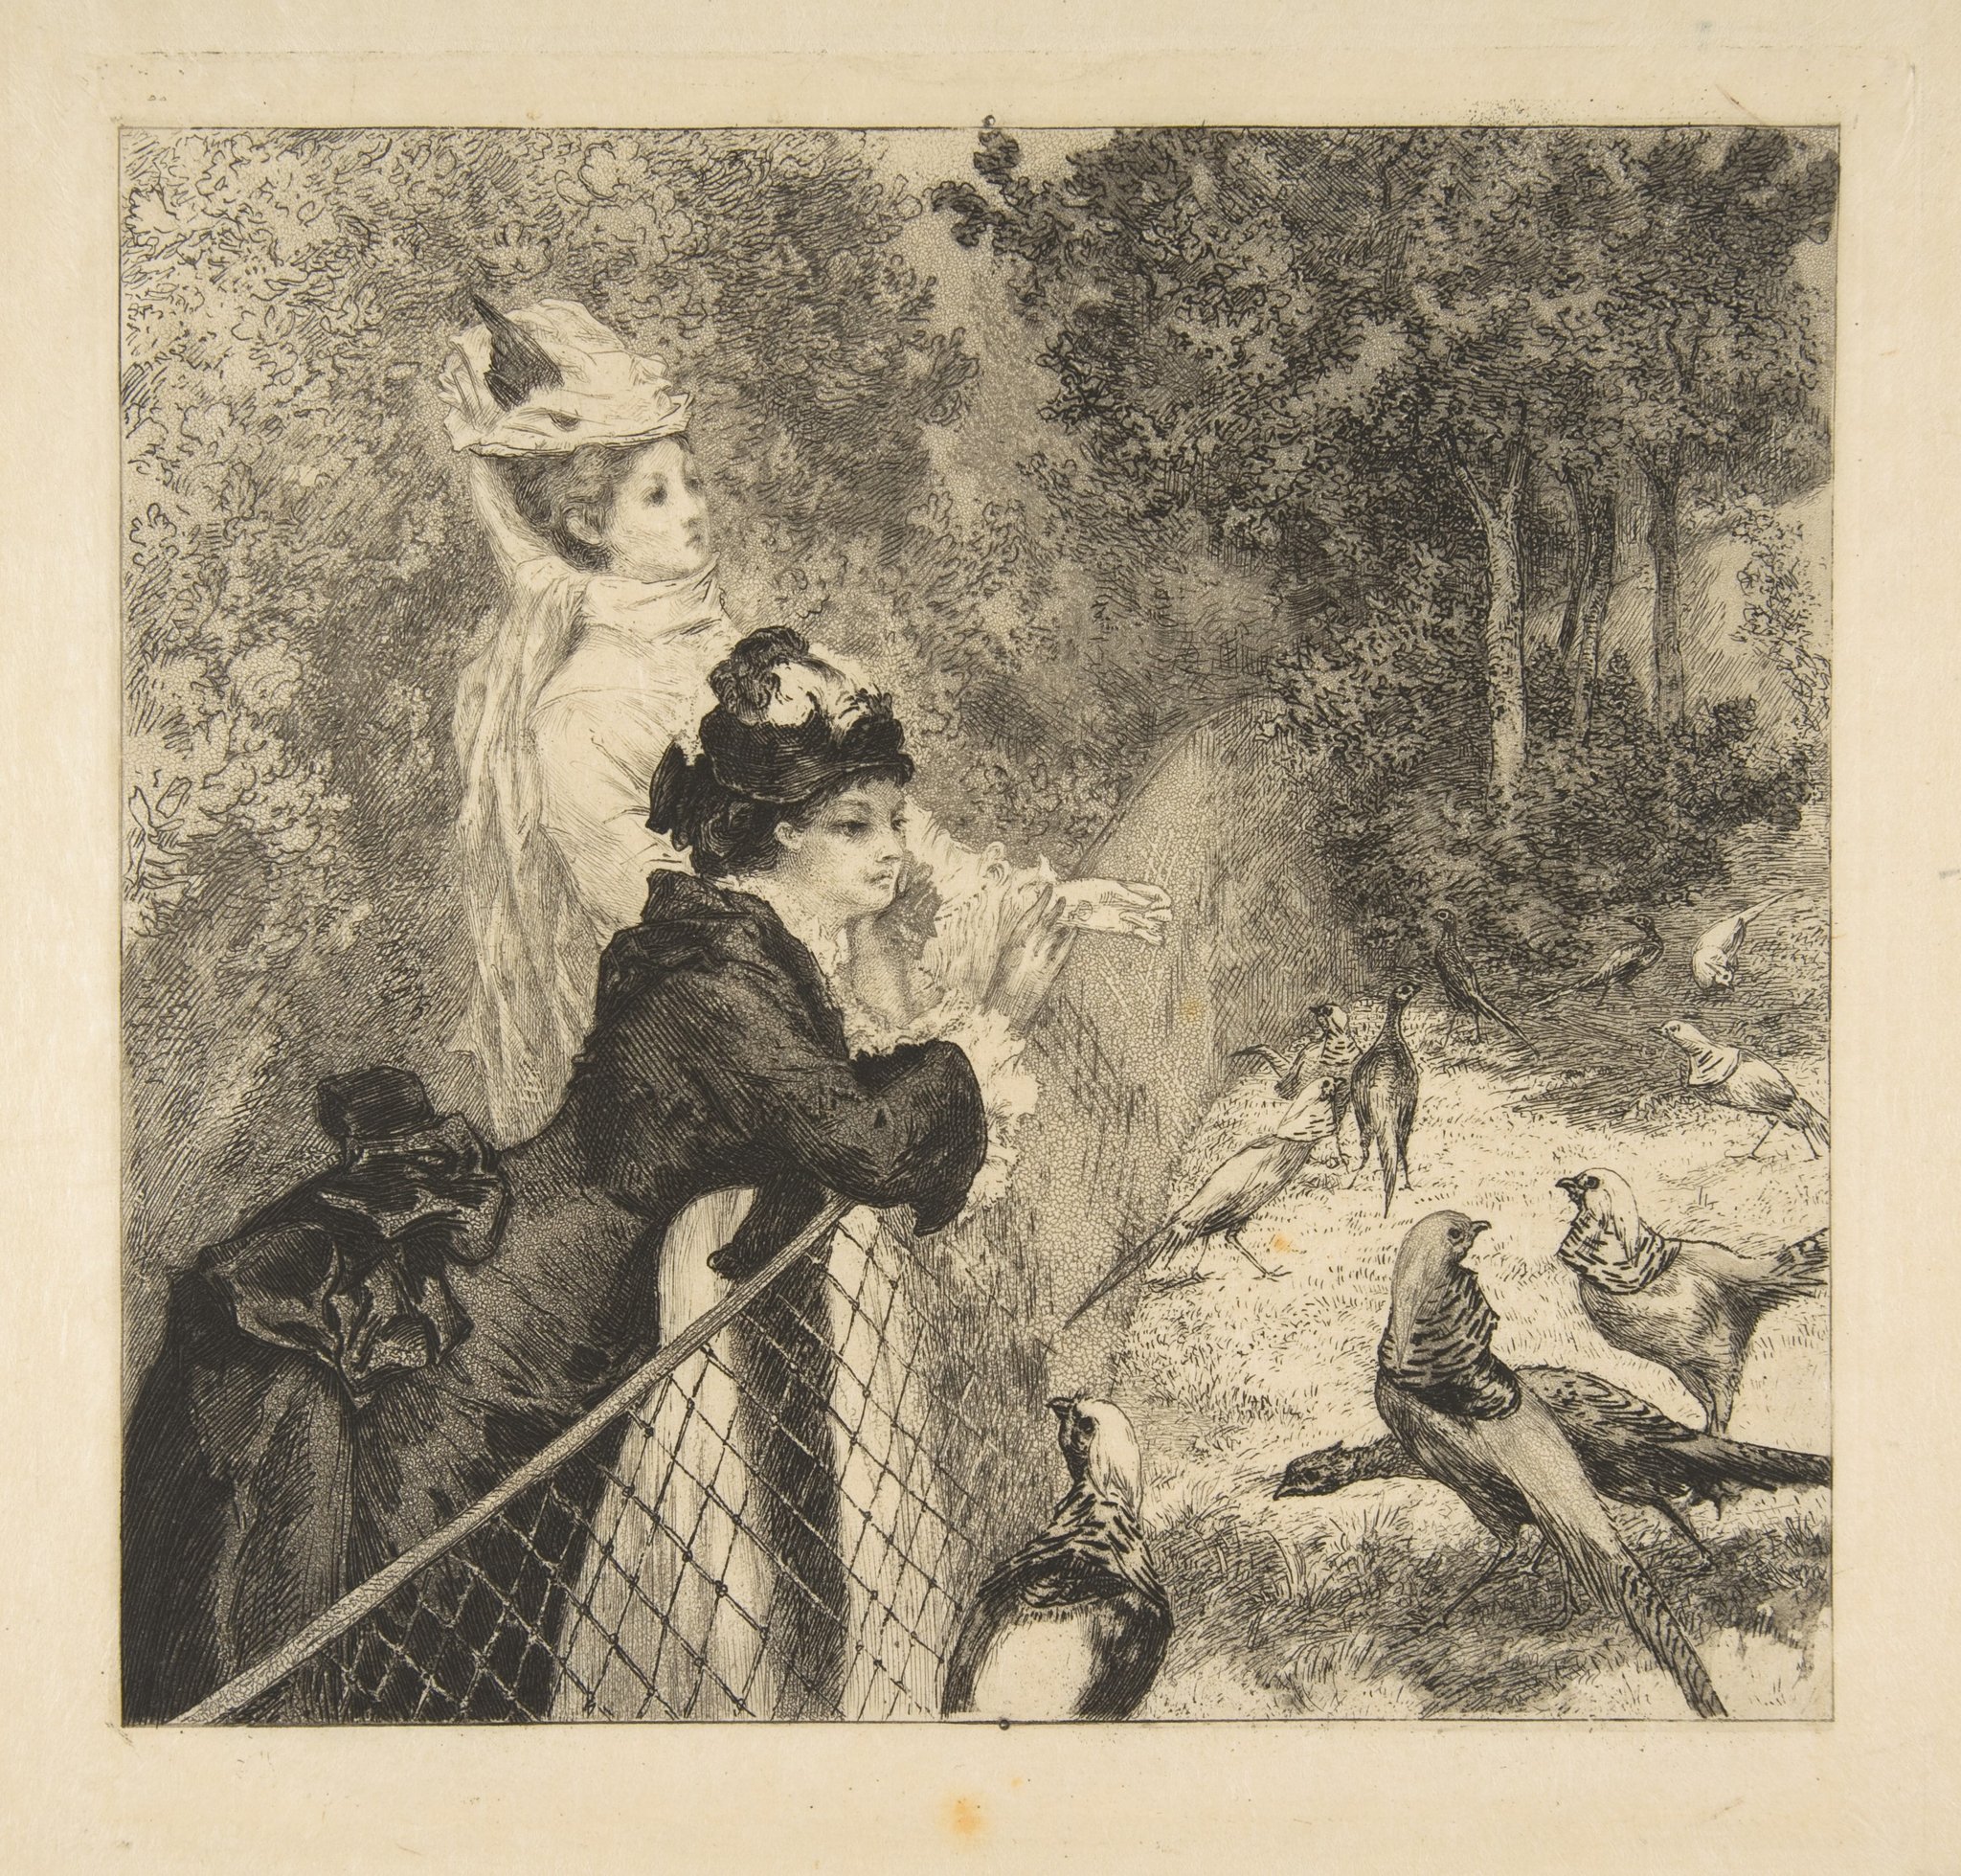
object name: print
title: In the Zoological Garden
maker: félix bracquemond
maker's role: artist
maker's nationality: french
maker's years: 1833-1914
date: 1873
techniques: aquatint, drypoint, etching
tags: birds,gardens,women,trees